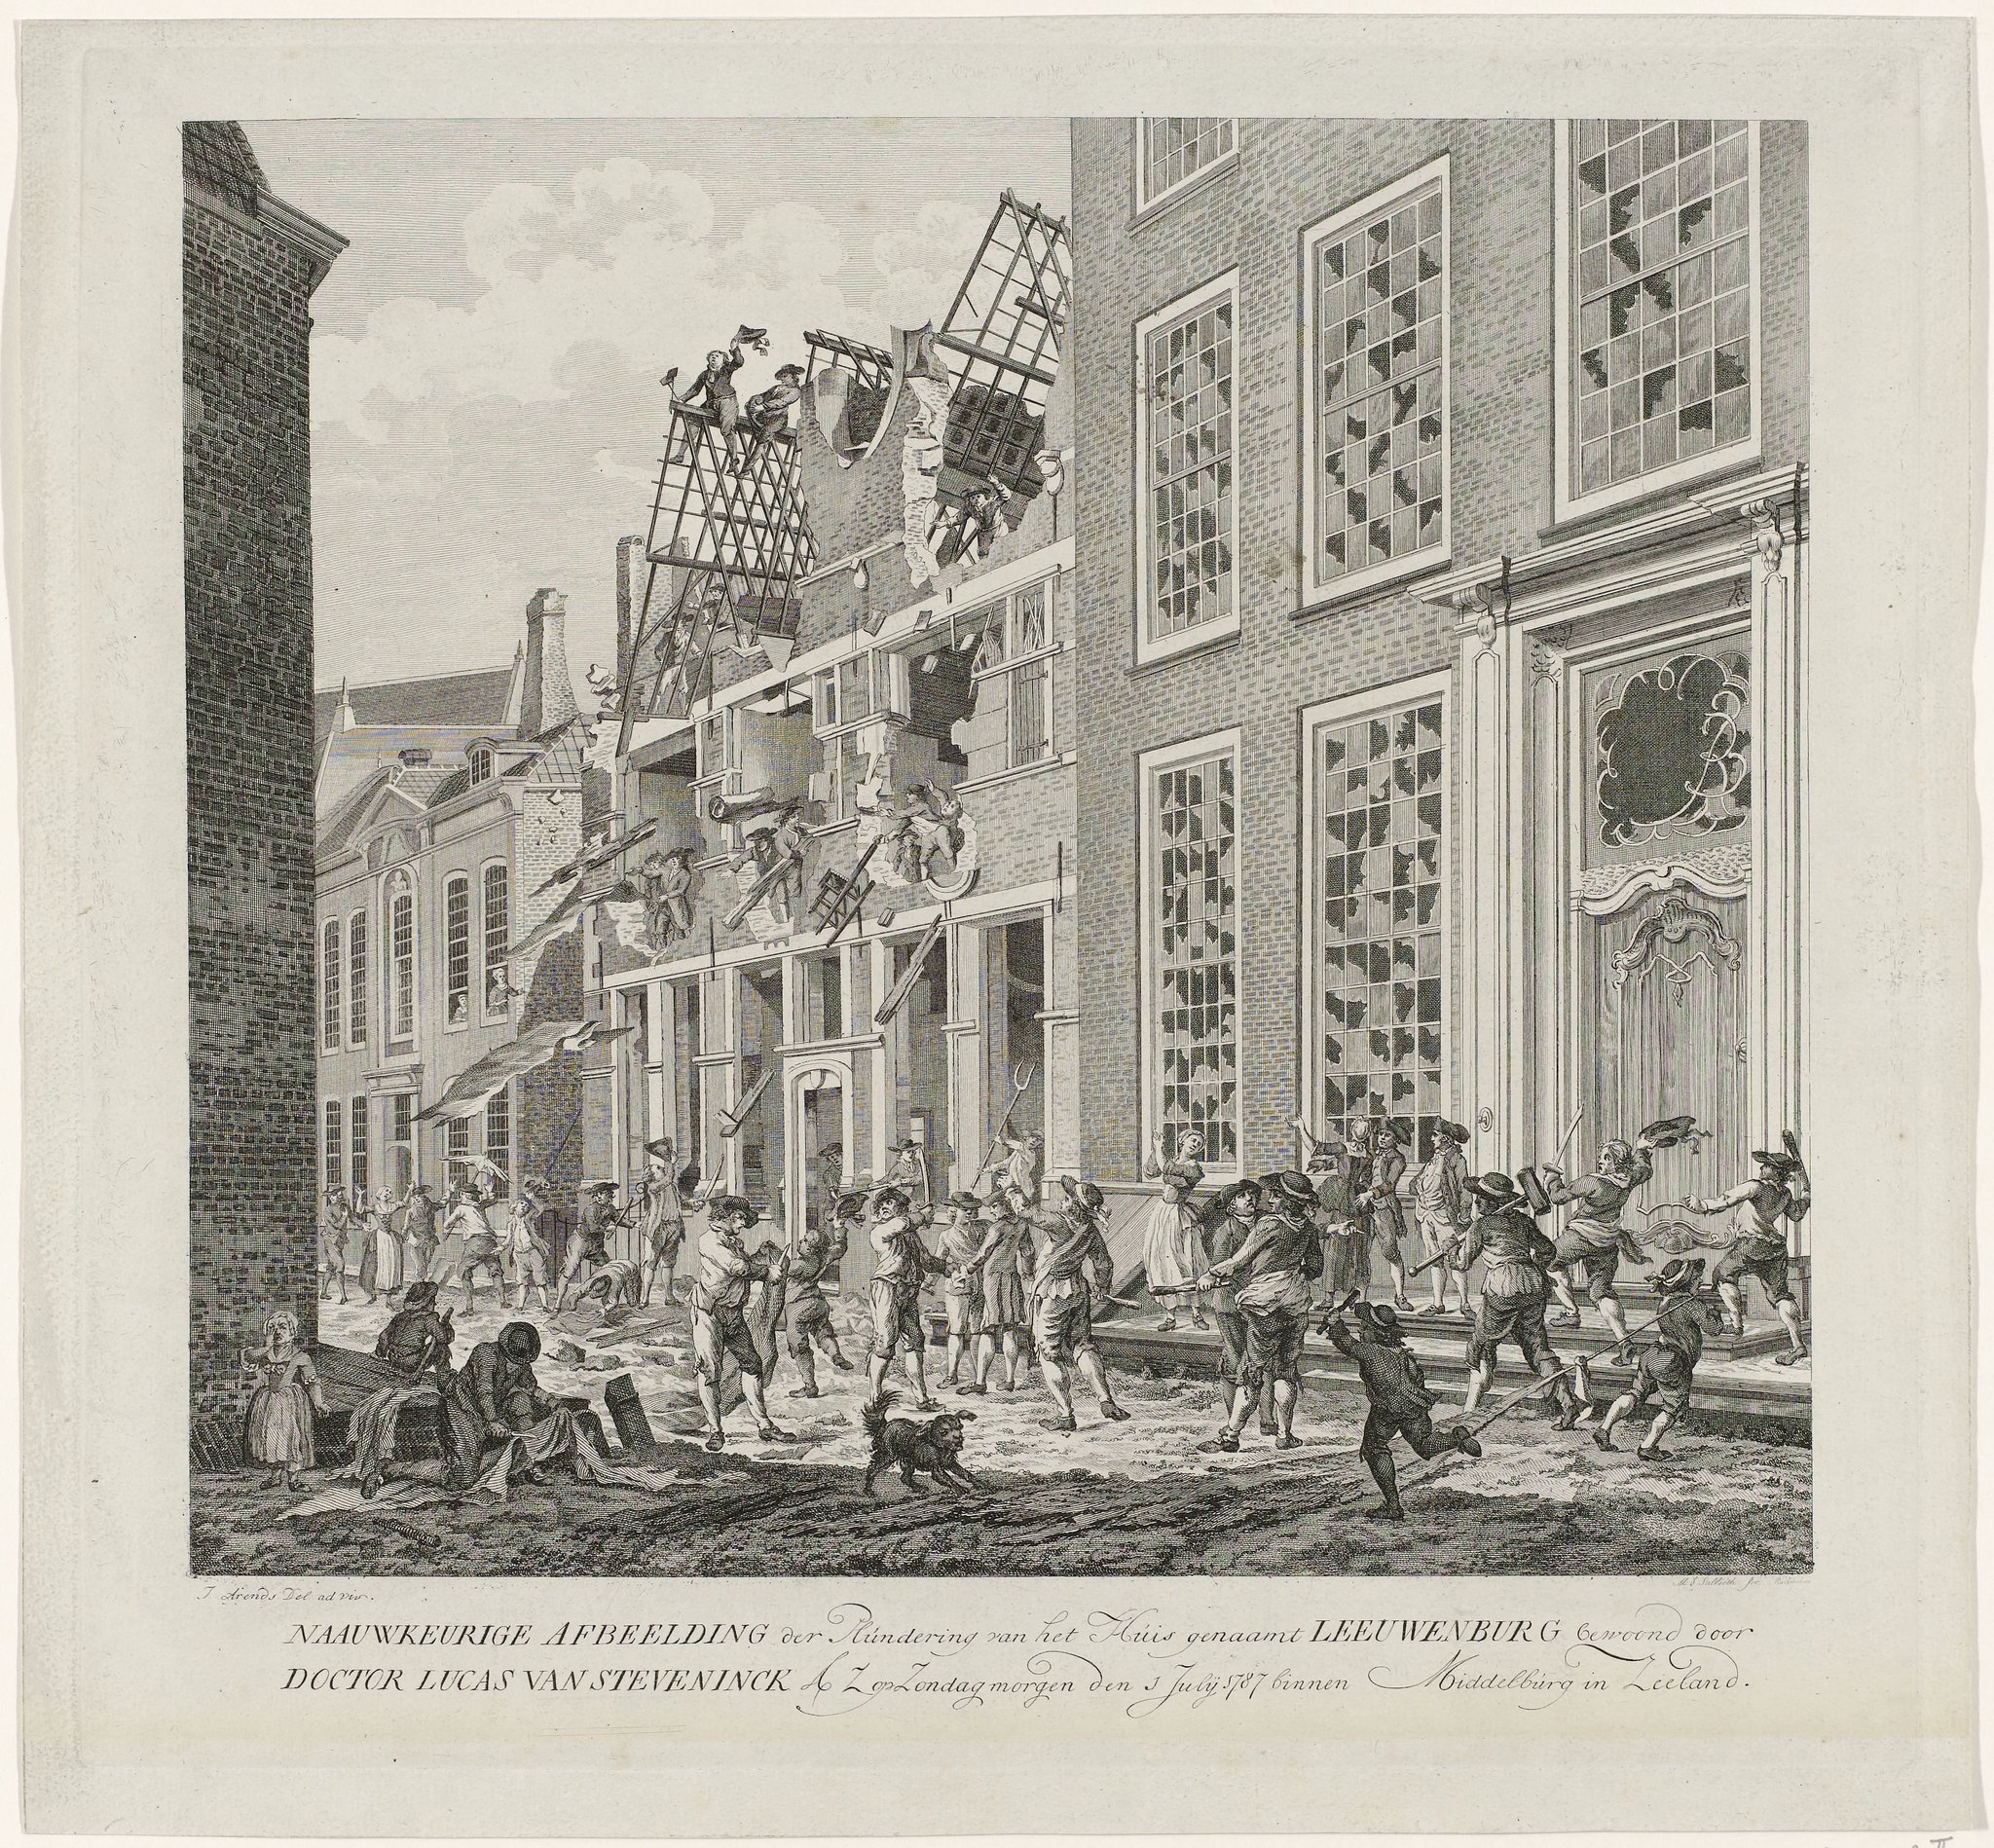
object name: print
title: Naauwkeurige Afbeelding der Plundering van het Huis genaamt Leeuwenburg bewoond door Doctor Lucas van Steveninck AZ op Zondagmorgen den 1 Julij 1787 binnen Middelburg in Zeeland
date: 1787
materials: paper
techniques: engraving, etching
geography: rotterdam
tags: amsterdam, plundering ~ riot, patriots (1780-1795)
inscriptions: collector's mark: Lugt 2228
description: Oranjegezinden plunderen het kapotgeschoten Huis Leeuwenburg van de patriotse arts Lucas van Steveninck, 1 juli 1787, te Middelburg.